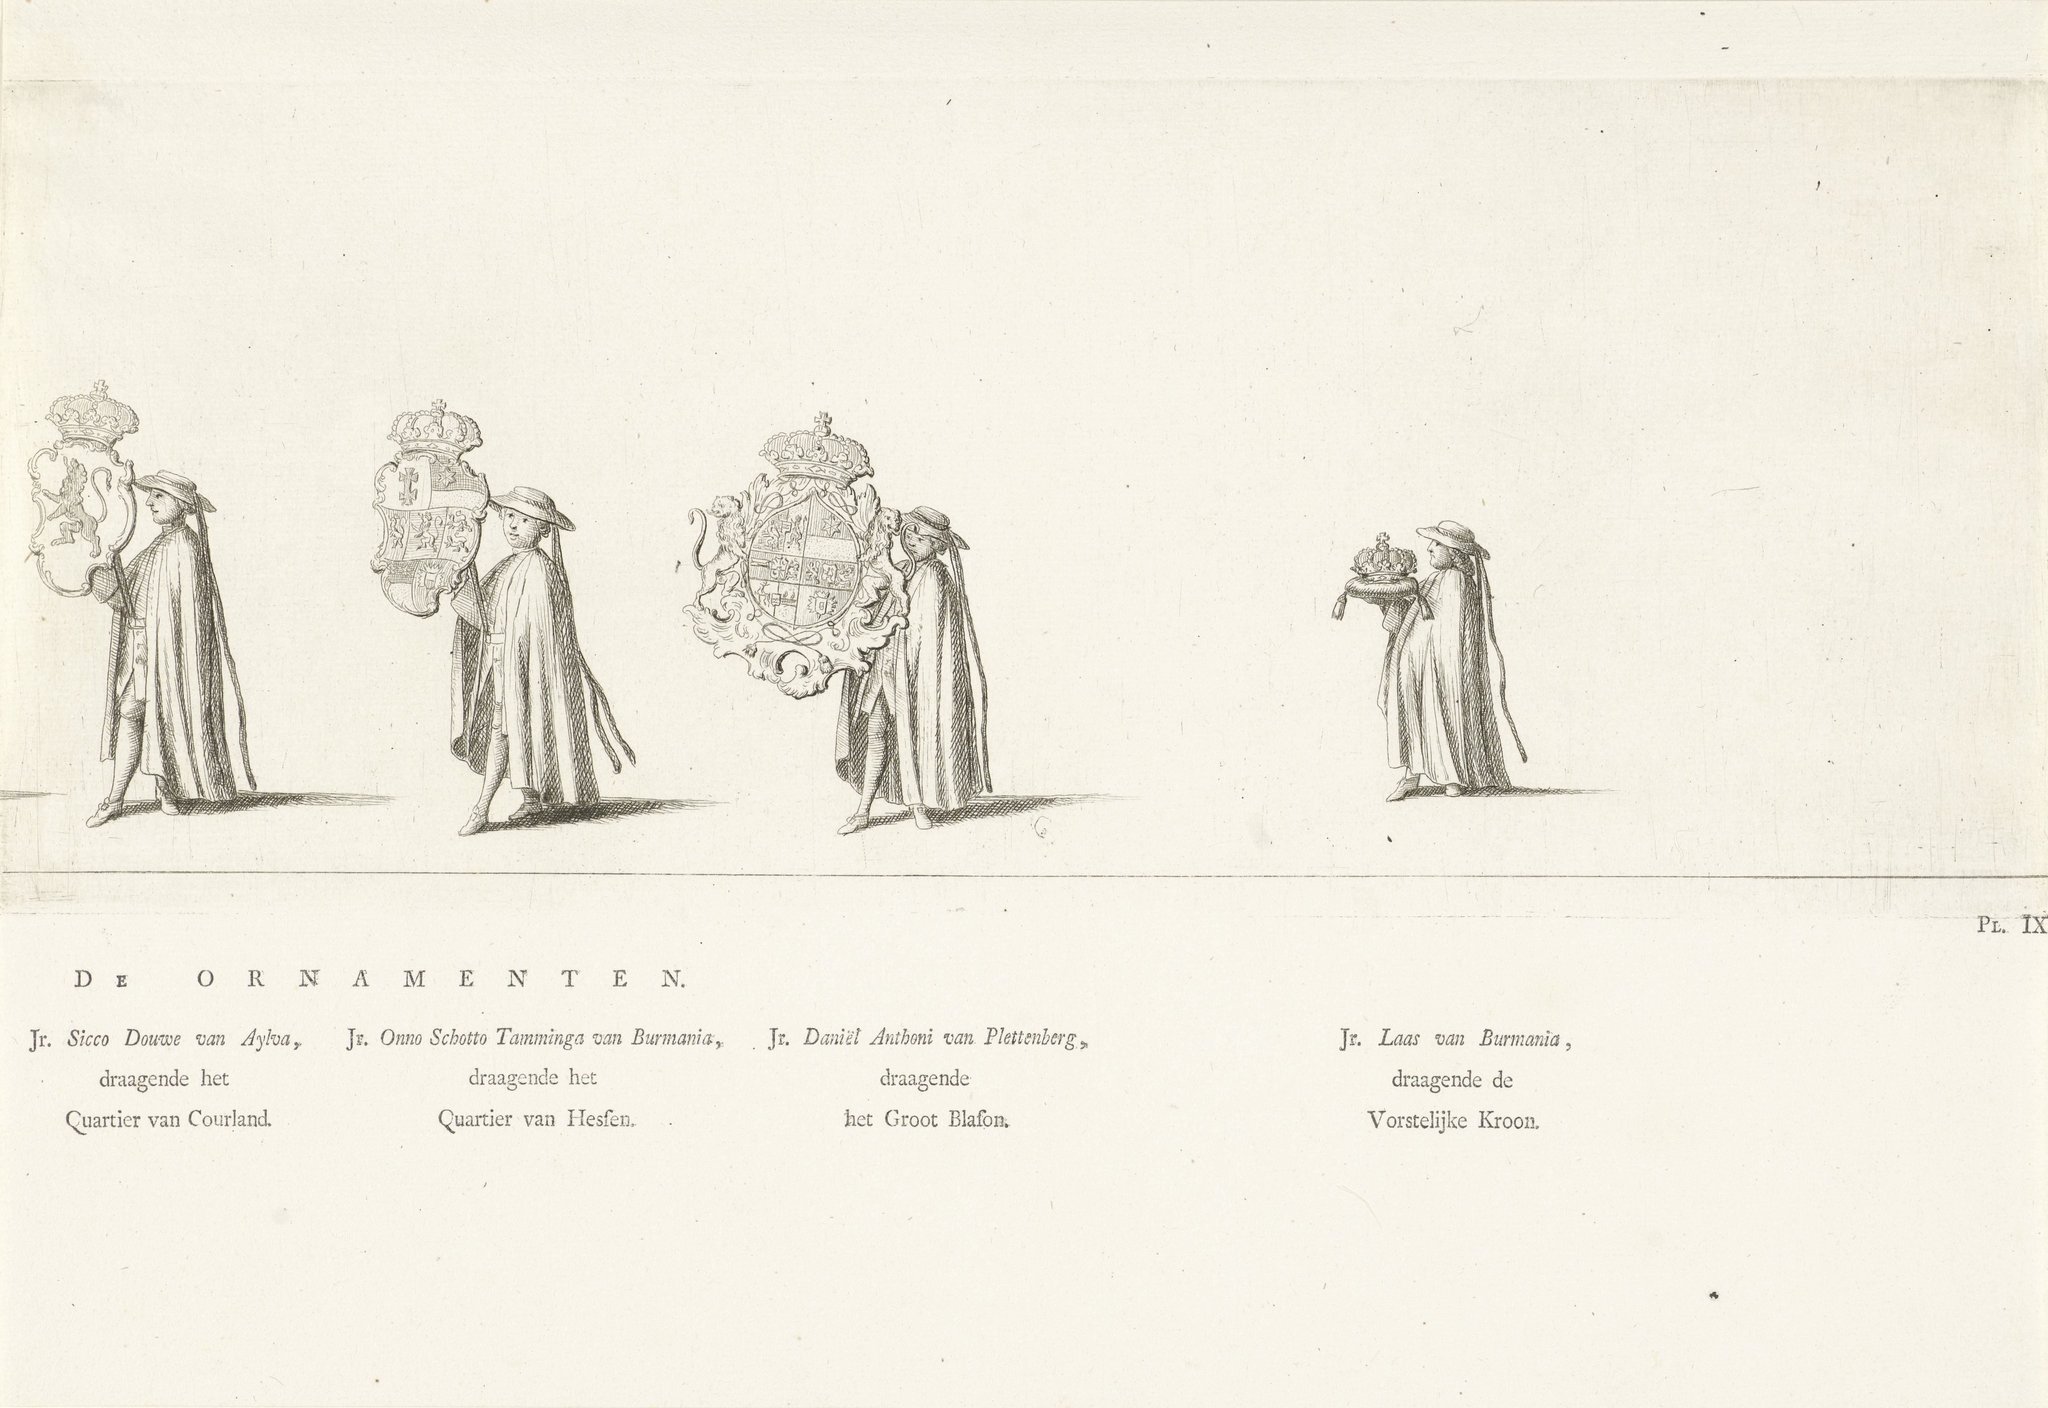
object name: print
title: Dragers van insignia in de begrafenisstoet van prinses Maria Louise, 1765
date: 1765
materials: paper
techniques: etching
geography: leeuwarden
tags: cortege, funeral procession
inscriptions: collector's mark: Lugt 2228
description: Edelen met de kwartieren van het stadhouderlijk wapen en de vorstelijke kroon. Gemerkt rechtsonder: Pl. IX. Op het blad onder de plaat de namen van personen in de stoet. Onderdeel van de serie platen van de begrafenis van prinses Maria Louise te Leeuwarden op 13 juni 1765.